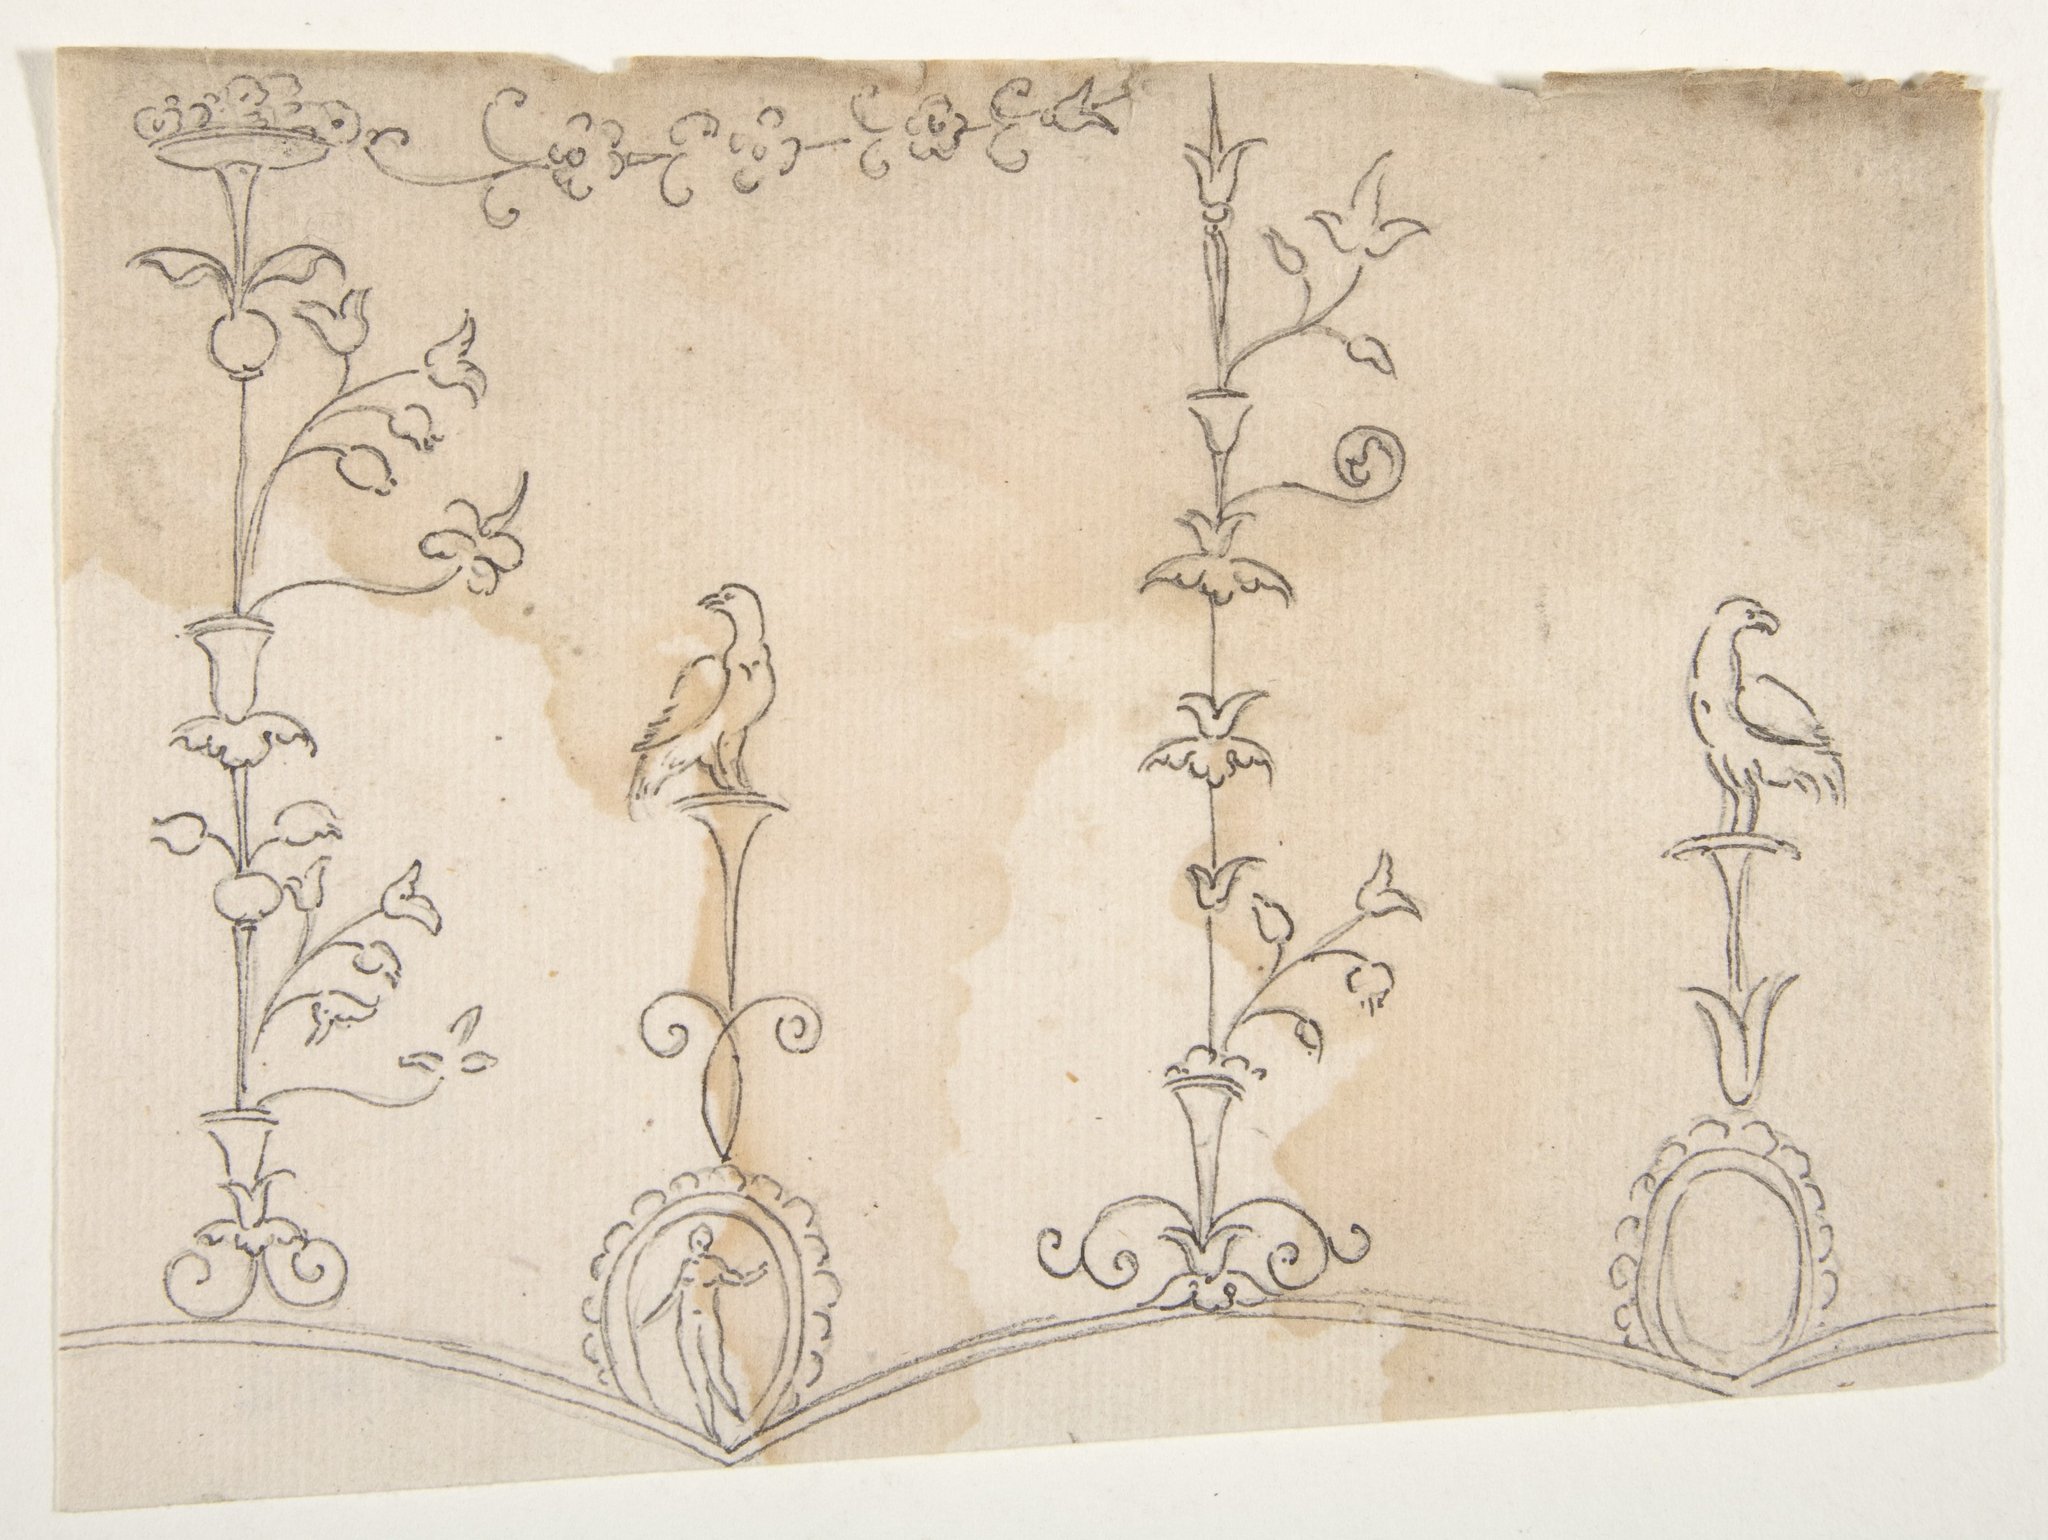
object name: collection ornament architecture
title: Domus Aurea, unidentified, grotteschi, details (recto) blank (verso)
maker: anonymous, french, 16th century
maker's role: draftsman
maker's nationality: french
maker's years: 1500-1600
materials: chalk, ink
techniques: incising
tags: birds,plants